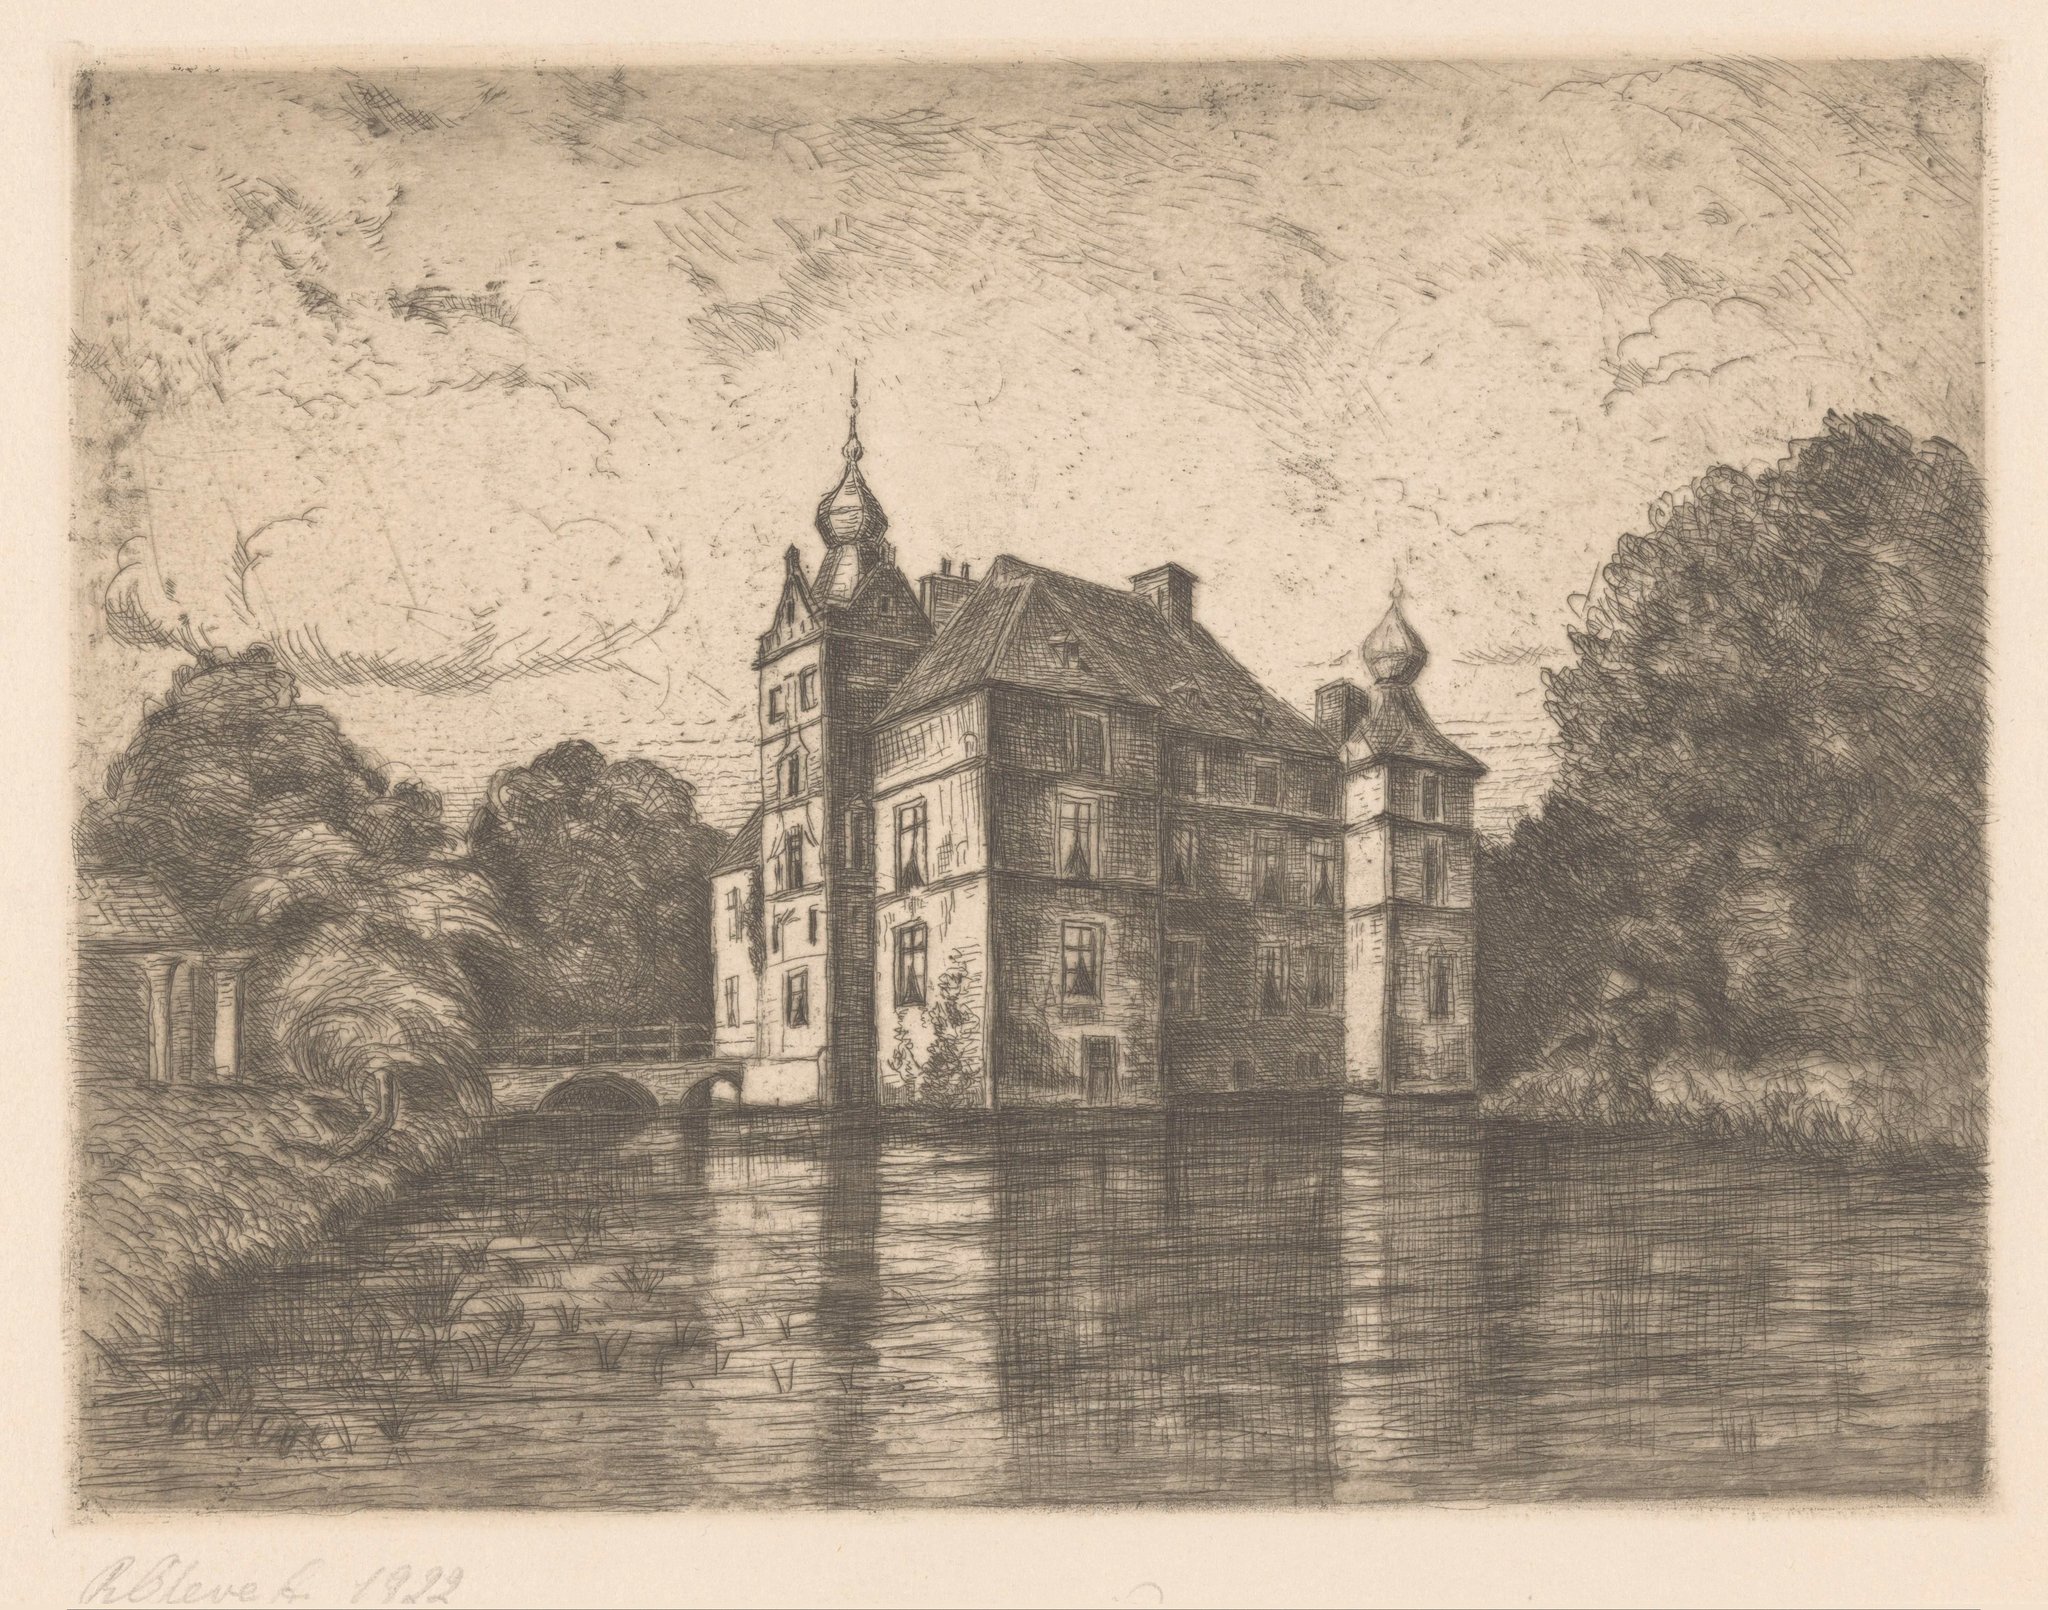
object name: print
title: Kasteel De Cannenburgh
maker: r. cleve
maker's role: print maker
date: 1922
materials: paper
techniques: etching, intaglio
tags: castle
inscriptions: collector's mark: Lugt 2228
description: Kasteel De Cannenburgh, schuin van voren gezien.